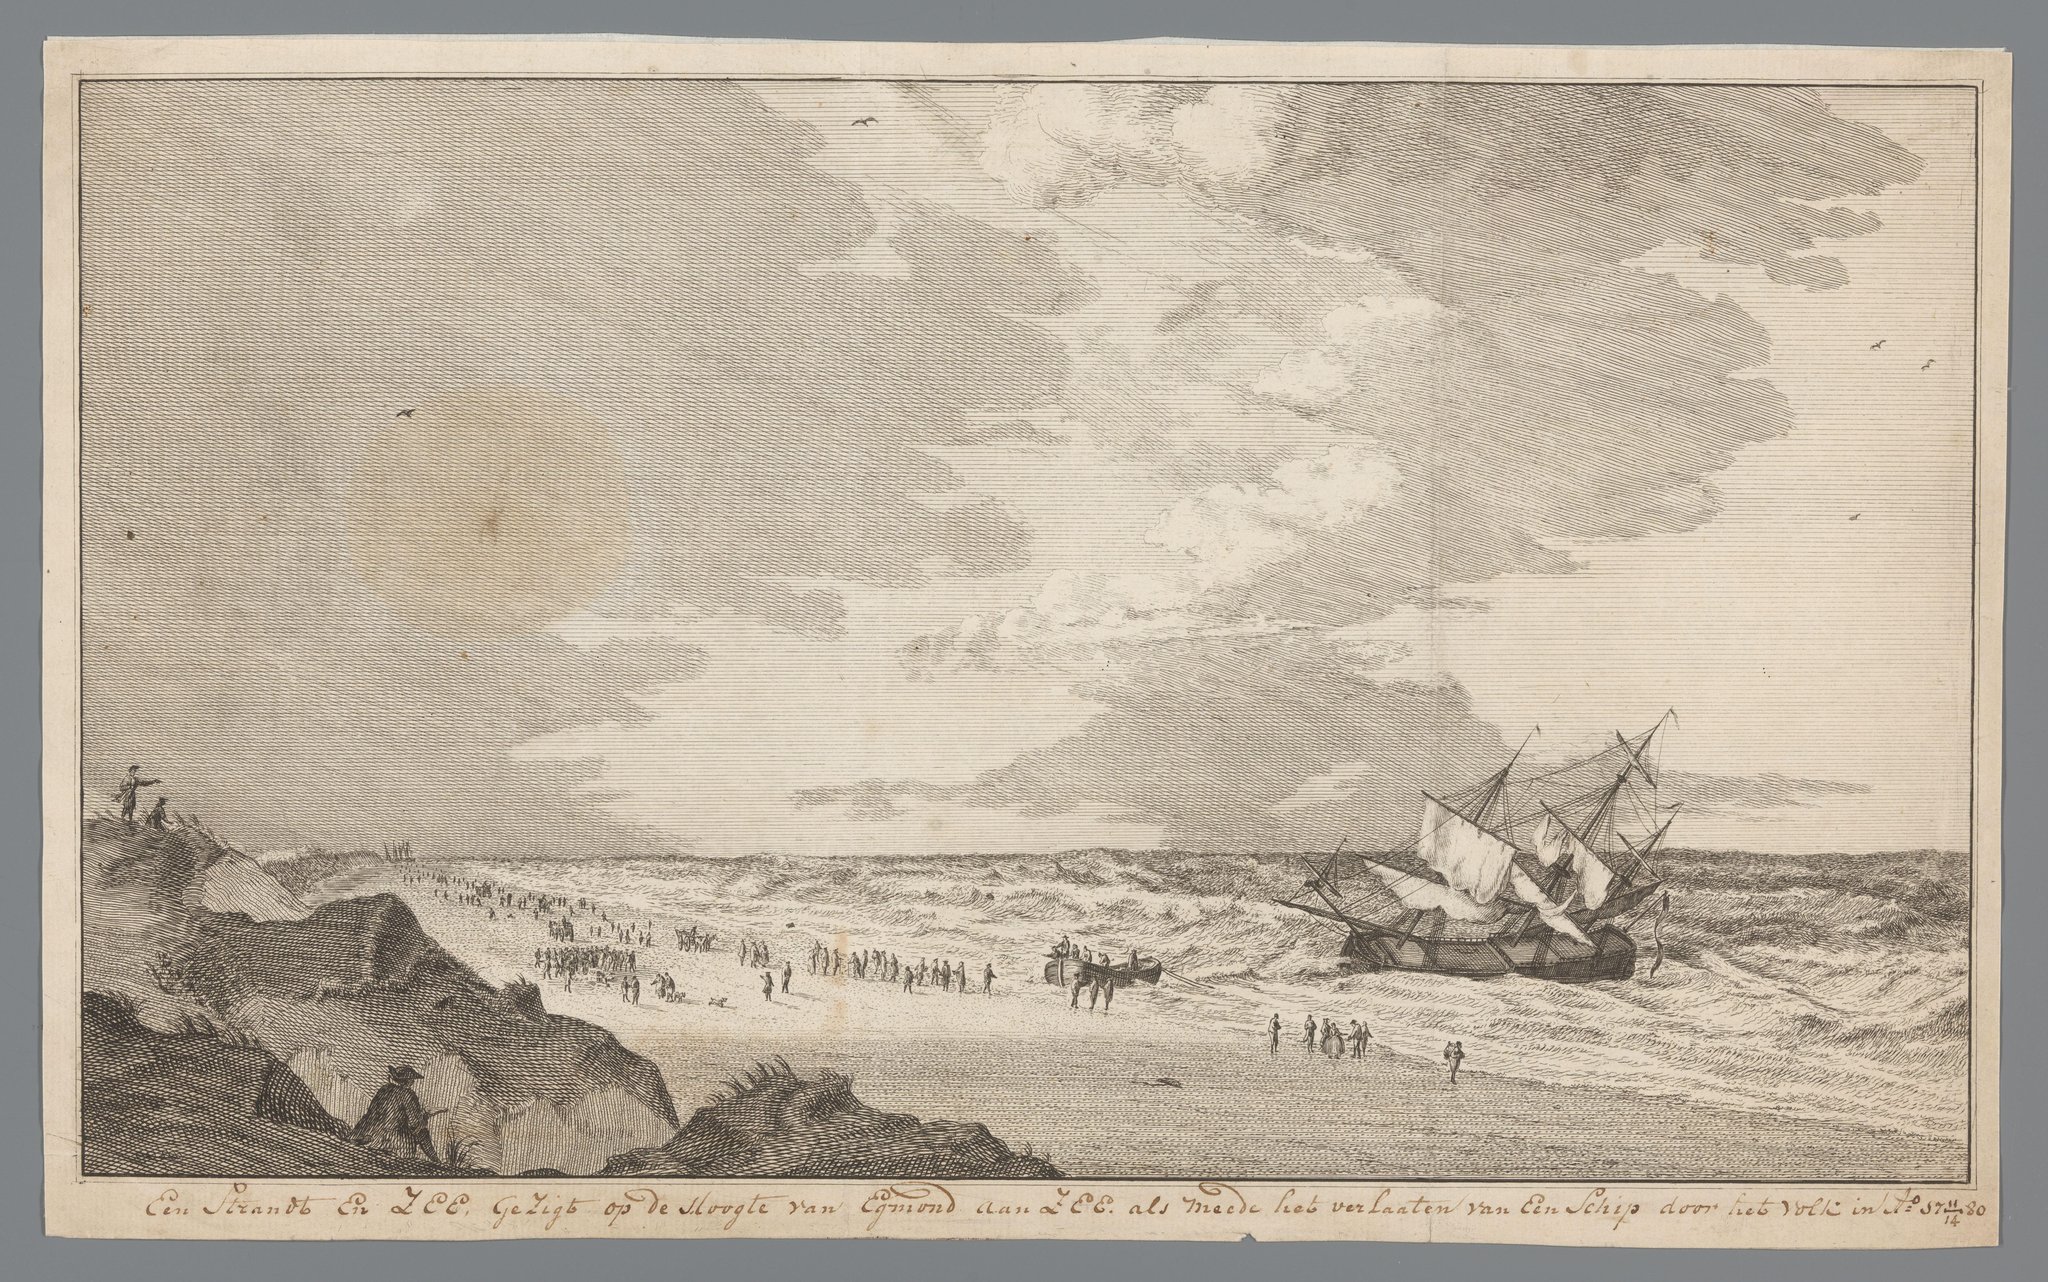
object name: print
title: Een strandt en zee, gezigt op de hoogte van Egmond aan Zee, als meede het verlaaten van een schip door het volk, 11-14 1780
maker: Anonymous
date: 1780-1782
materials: paper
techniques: engraving, etching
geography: northern netherlands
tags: shipwreck, beach (+ landscape with figures, staffage)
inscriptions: inscription: ‘Een strandt en zee, gezigt op de hoogte van Egmond aan Zee, als meede het verlaaten van een schip door het volk, 11-14 1780’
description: Deze prent ook bij Muller beschreven onder nummer FMH 3829 en vermeld bij 4403.